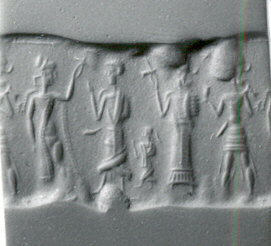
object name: cylinder seal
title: Cylinder seal and modern impression: partially nude and robed goddesses raising ankh symbols over a king; weather god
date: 1720-1650 BCE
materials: mineral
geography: syria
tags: goddess